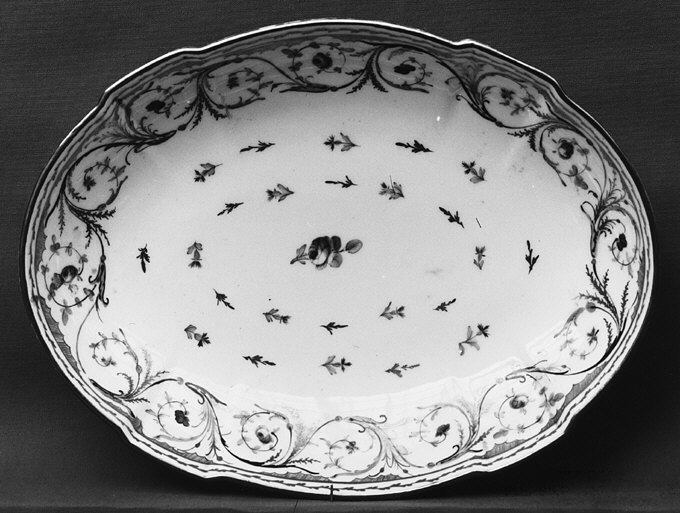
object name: tray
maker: bordeaux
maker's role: factory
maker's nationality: french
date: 1781-1787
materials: hard paste porcelain